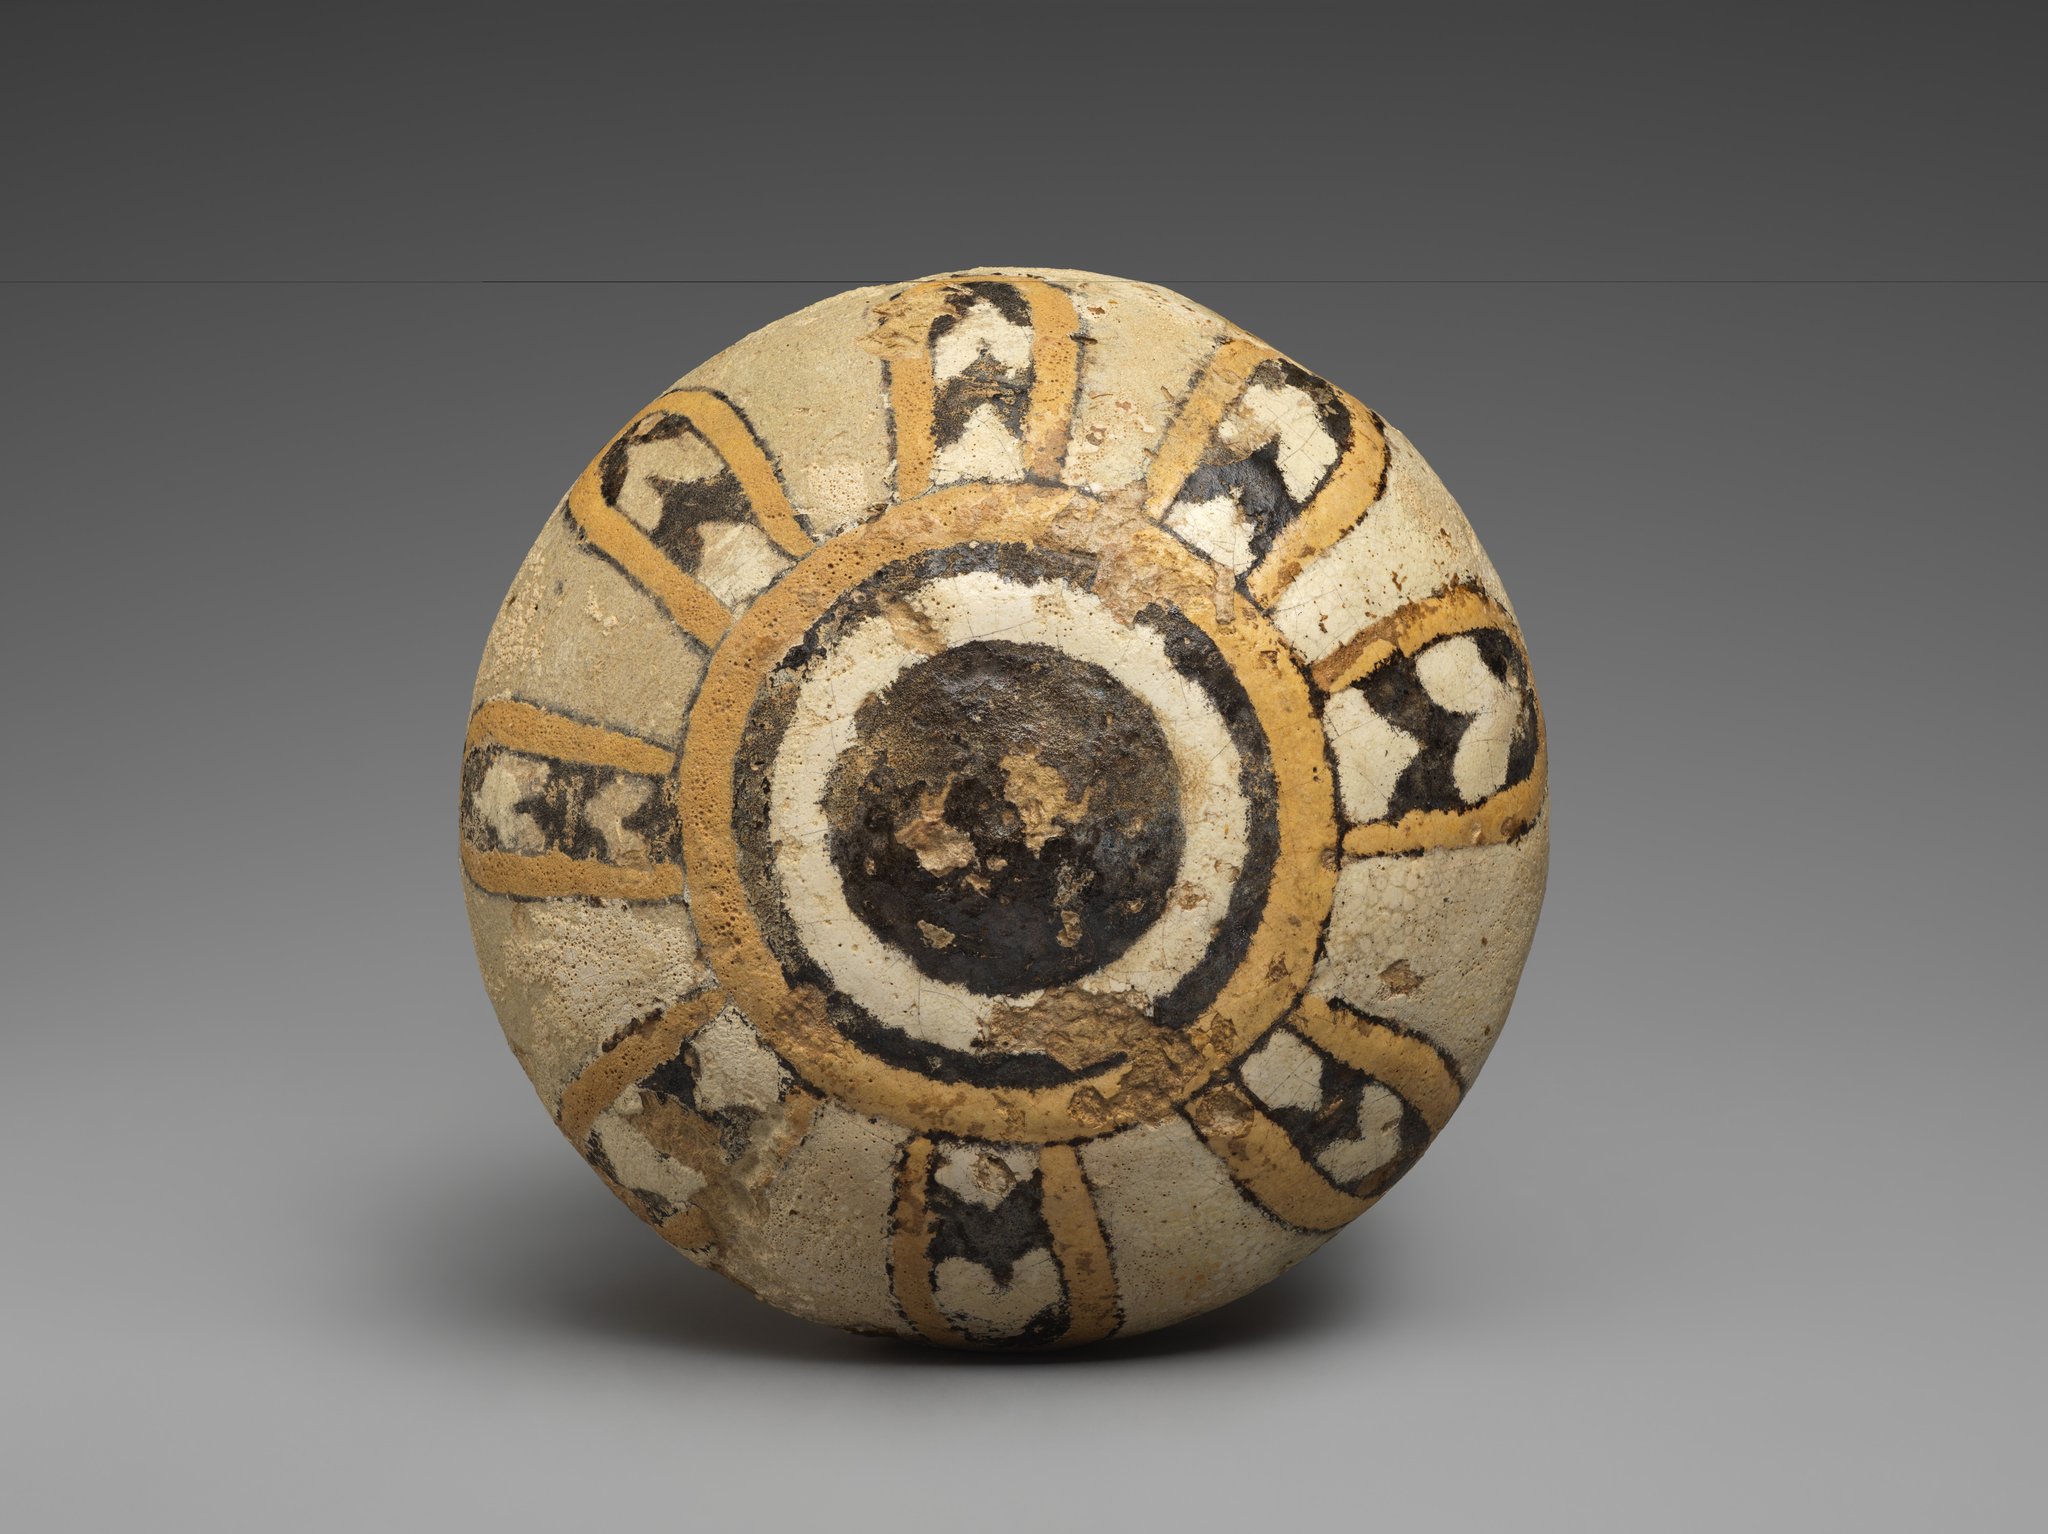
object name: knob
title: Knob with an eight-petaled rosette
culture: assyrian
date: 883-859 BCE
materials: ceramic, paint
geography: mesopotamia